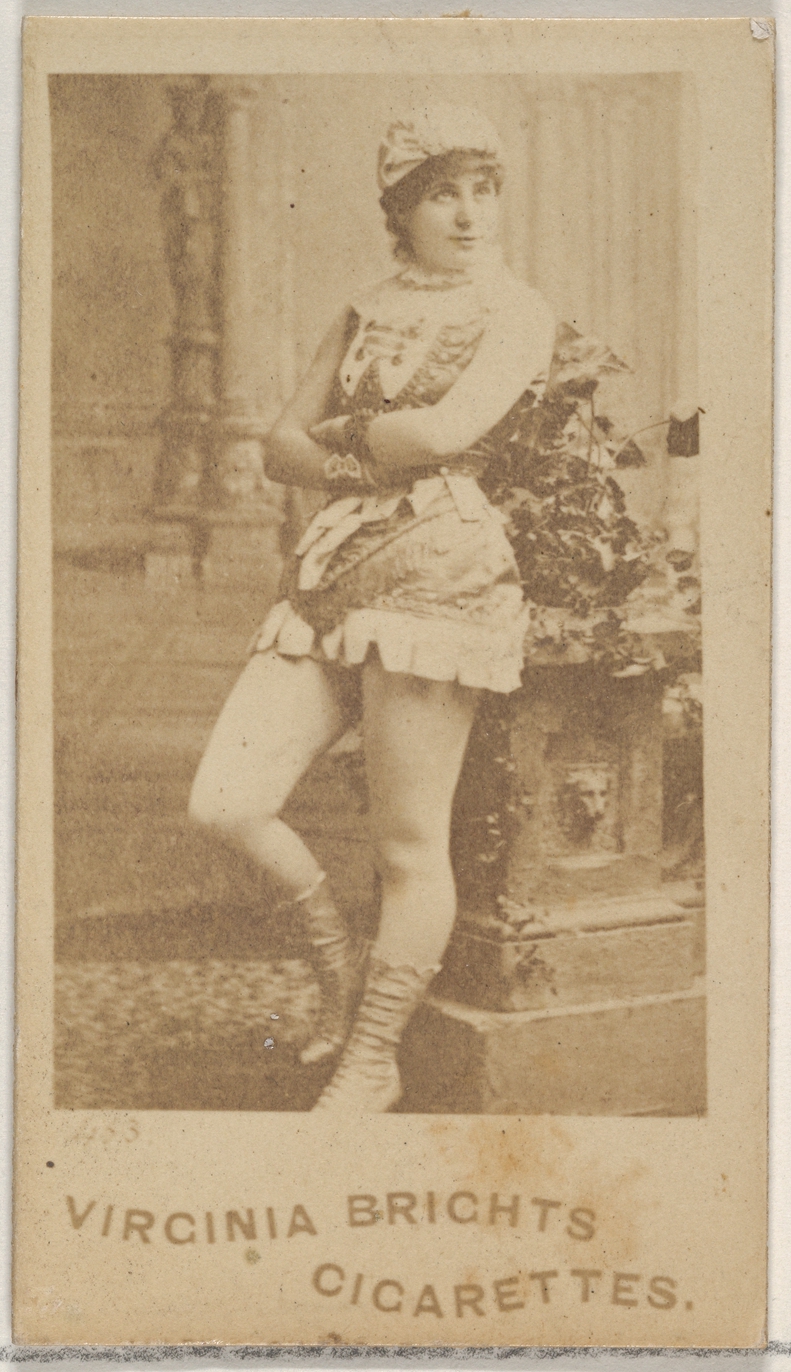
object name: photograph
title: Card 483, from the Actors and Actresses series (N45, Type 5) for Virginia Brights Cigarettes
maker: allen & ginter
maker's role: publisher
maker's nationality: american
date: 1888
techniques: albumen silver print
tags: portraits,women,actresses